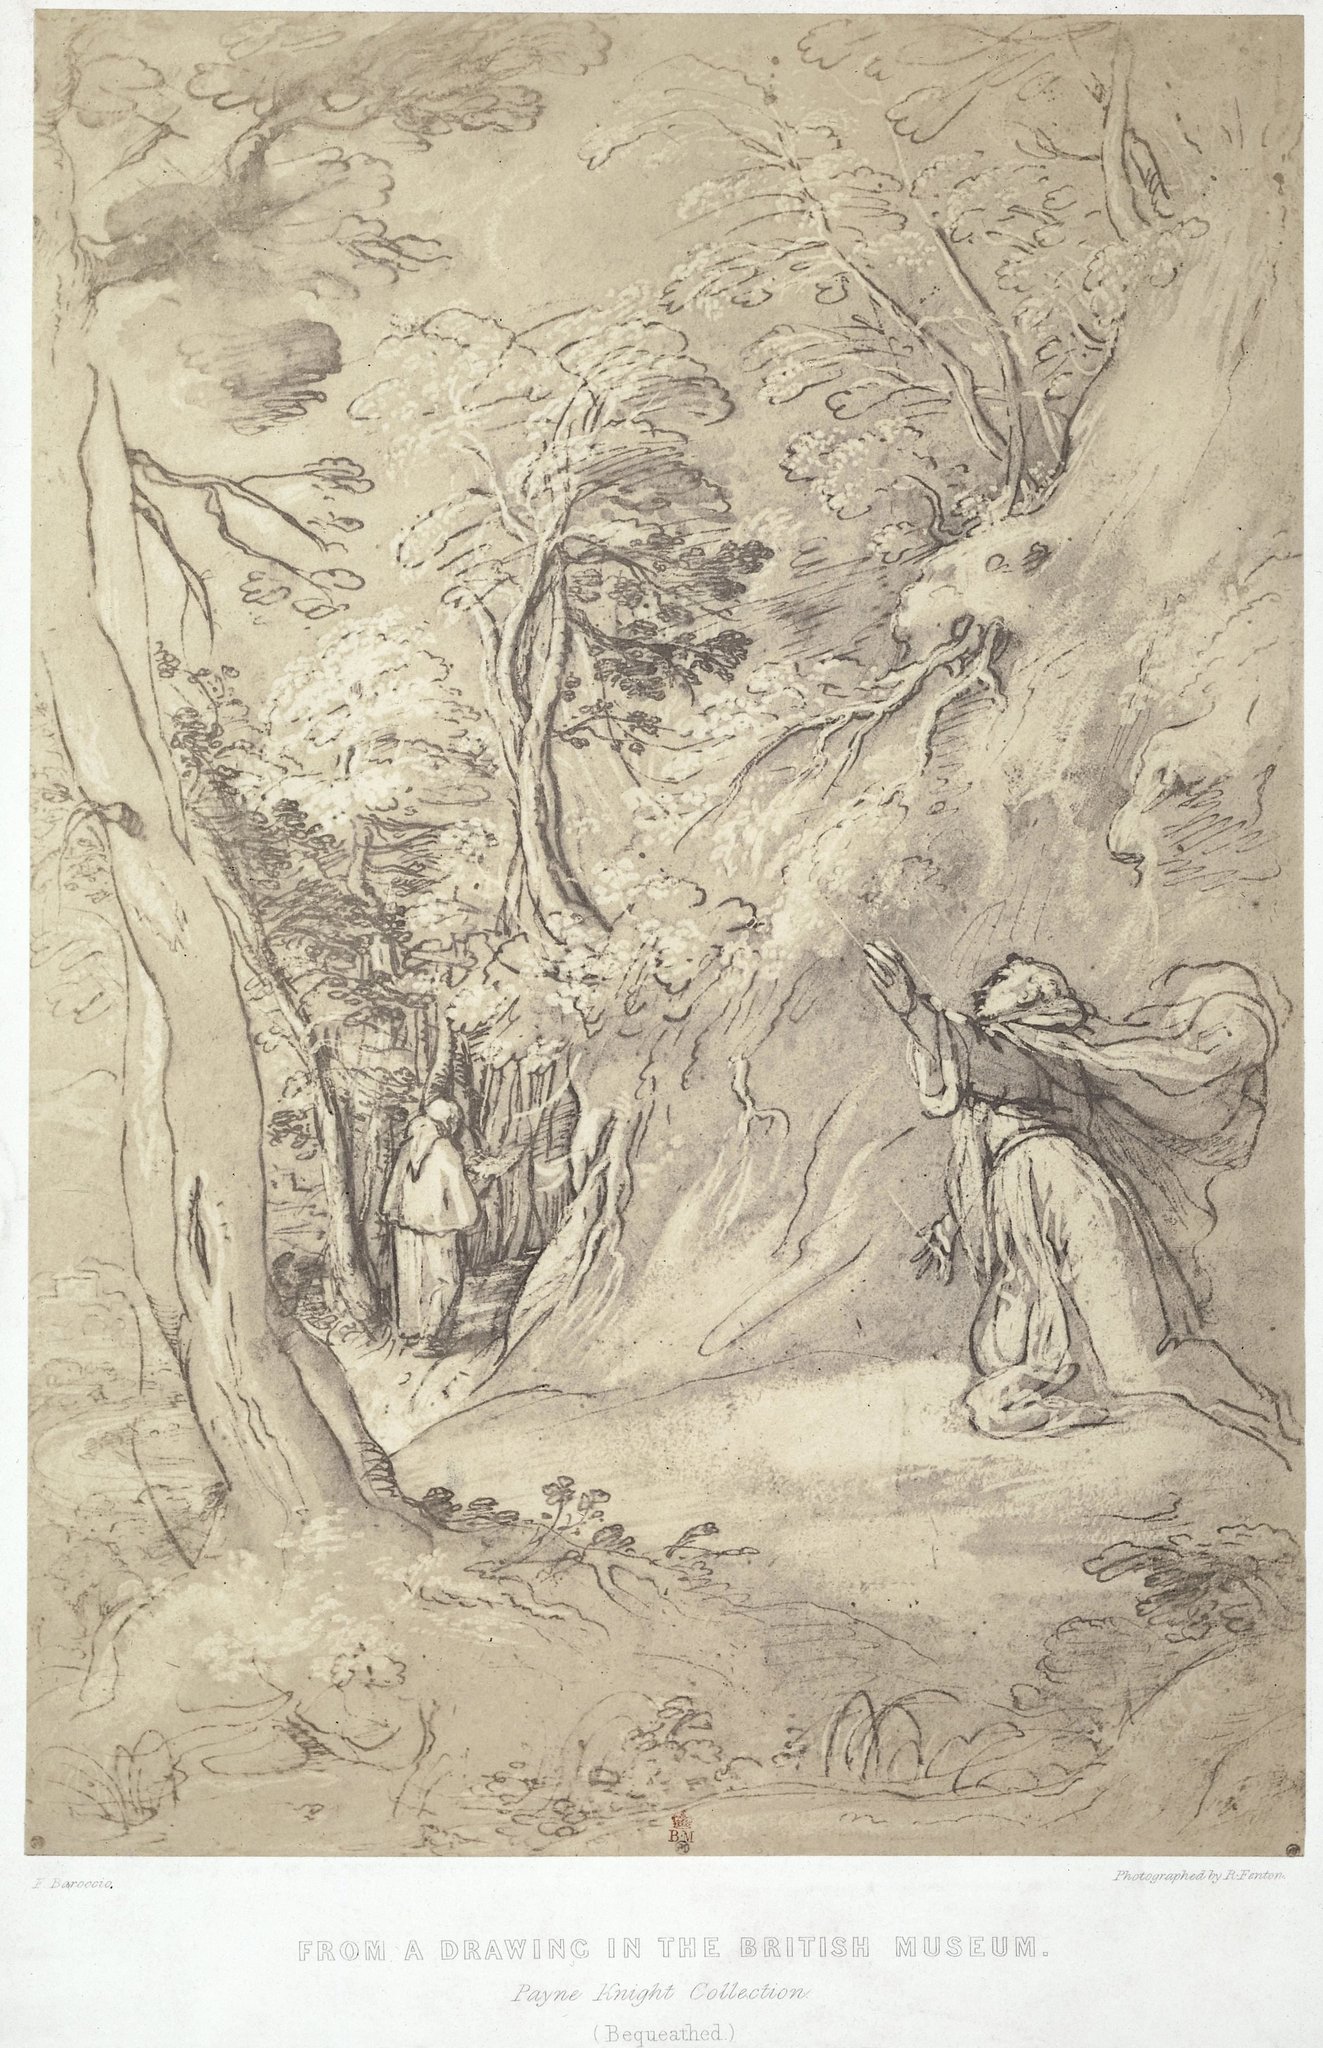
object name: photograph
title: Fotoreproductie van een tekening van Federico Barocci, 'De stigmatisering van Sint Franciscus'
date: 1858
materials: cardboard, photographic support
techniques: salted paper print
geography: london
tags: drawing, sketch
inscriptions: inscription: ‘From a drawing in the British Museum./ Payne Knight Collection./ (Bequeathed.)/ London, Published by the Trustees at the British Museum, 1858.’